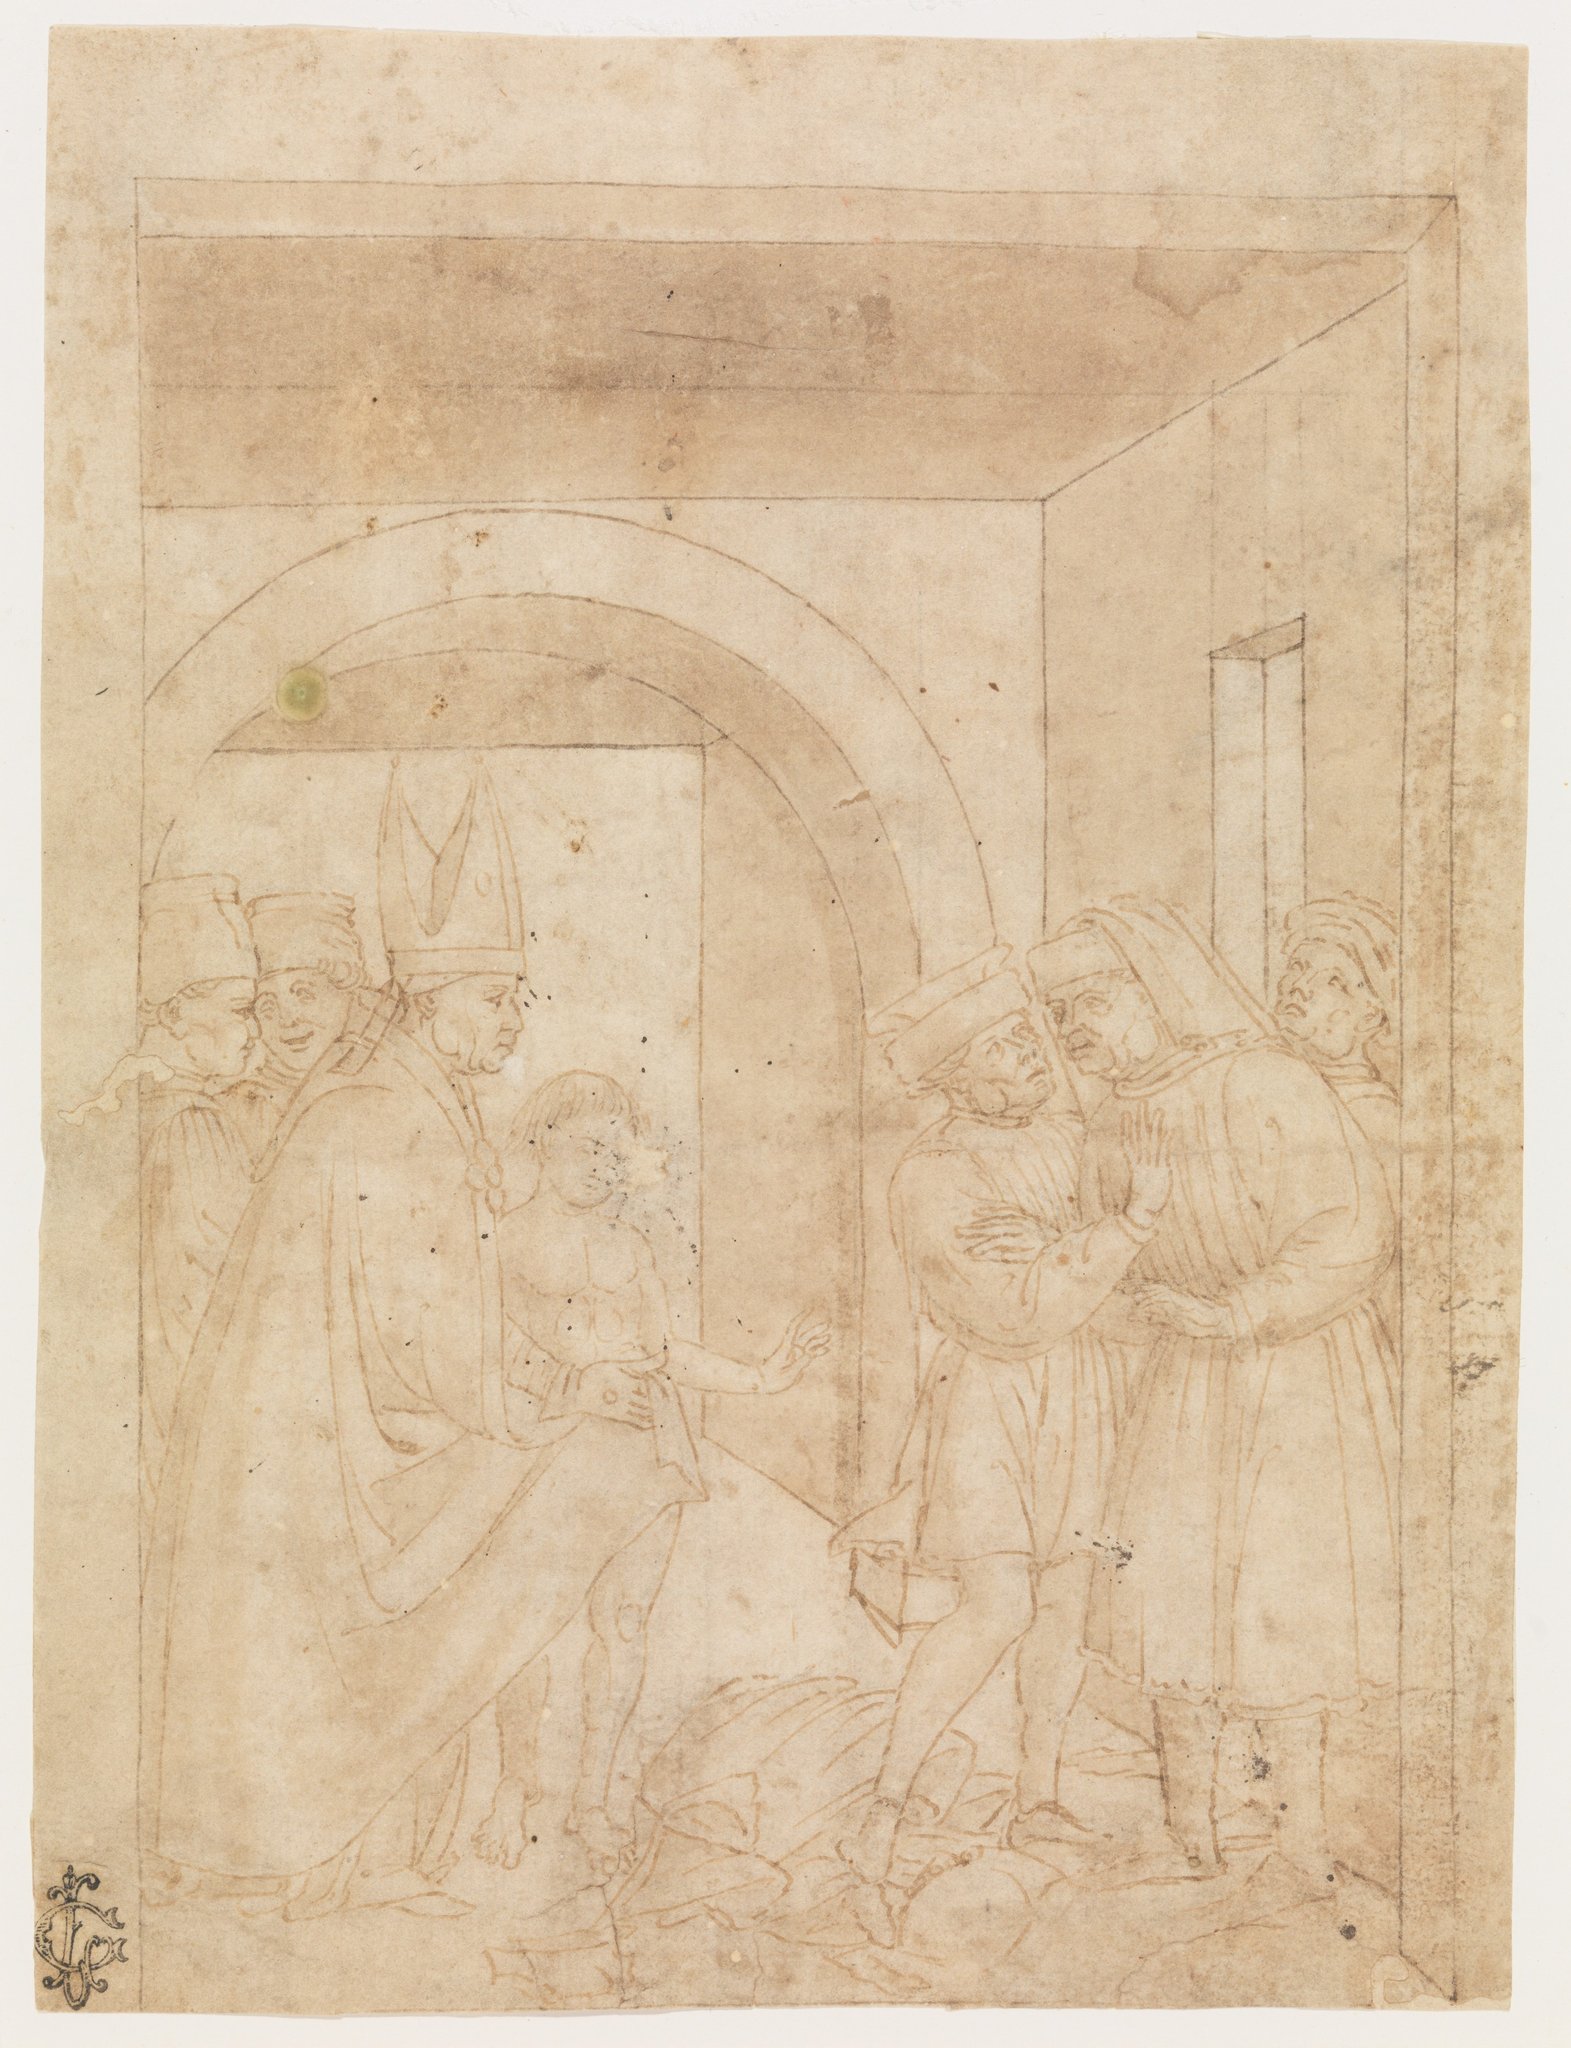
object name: drawing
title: Saint Francis Before the Bishop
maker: niccolò solimani (niccolò da verona)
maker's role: artist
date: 1469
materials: chalk, ink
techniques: pen, wash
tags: bishops,saint francis